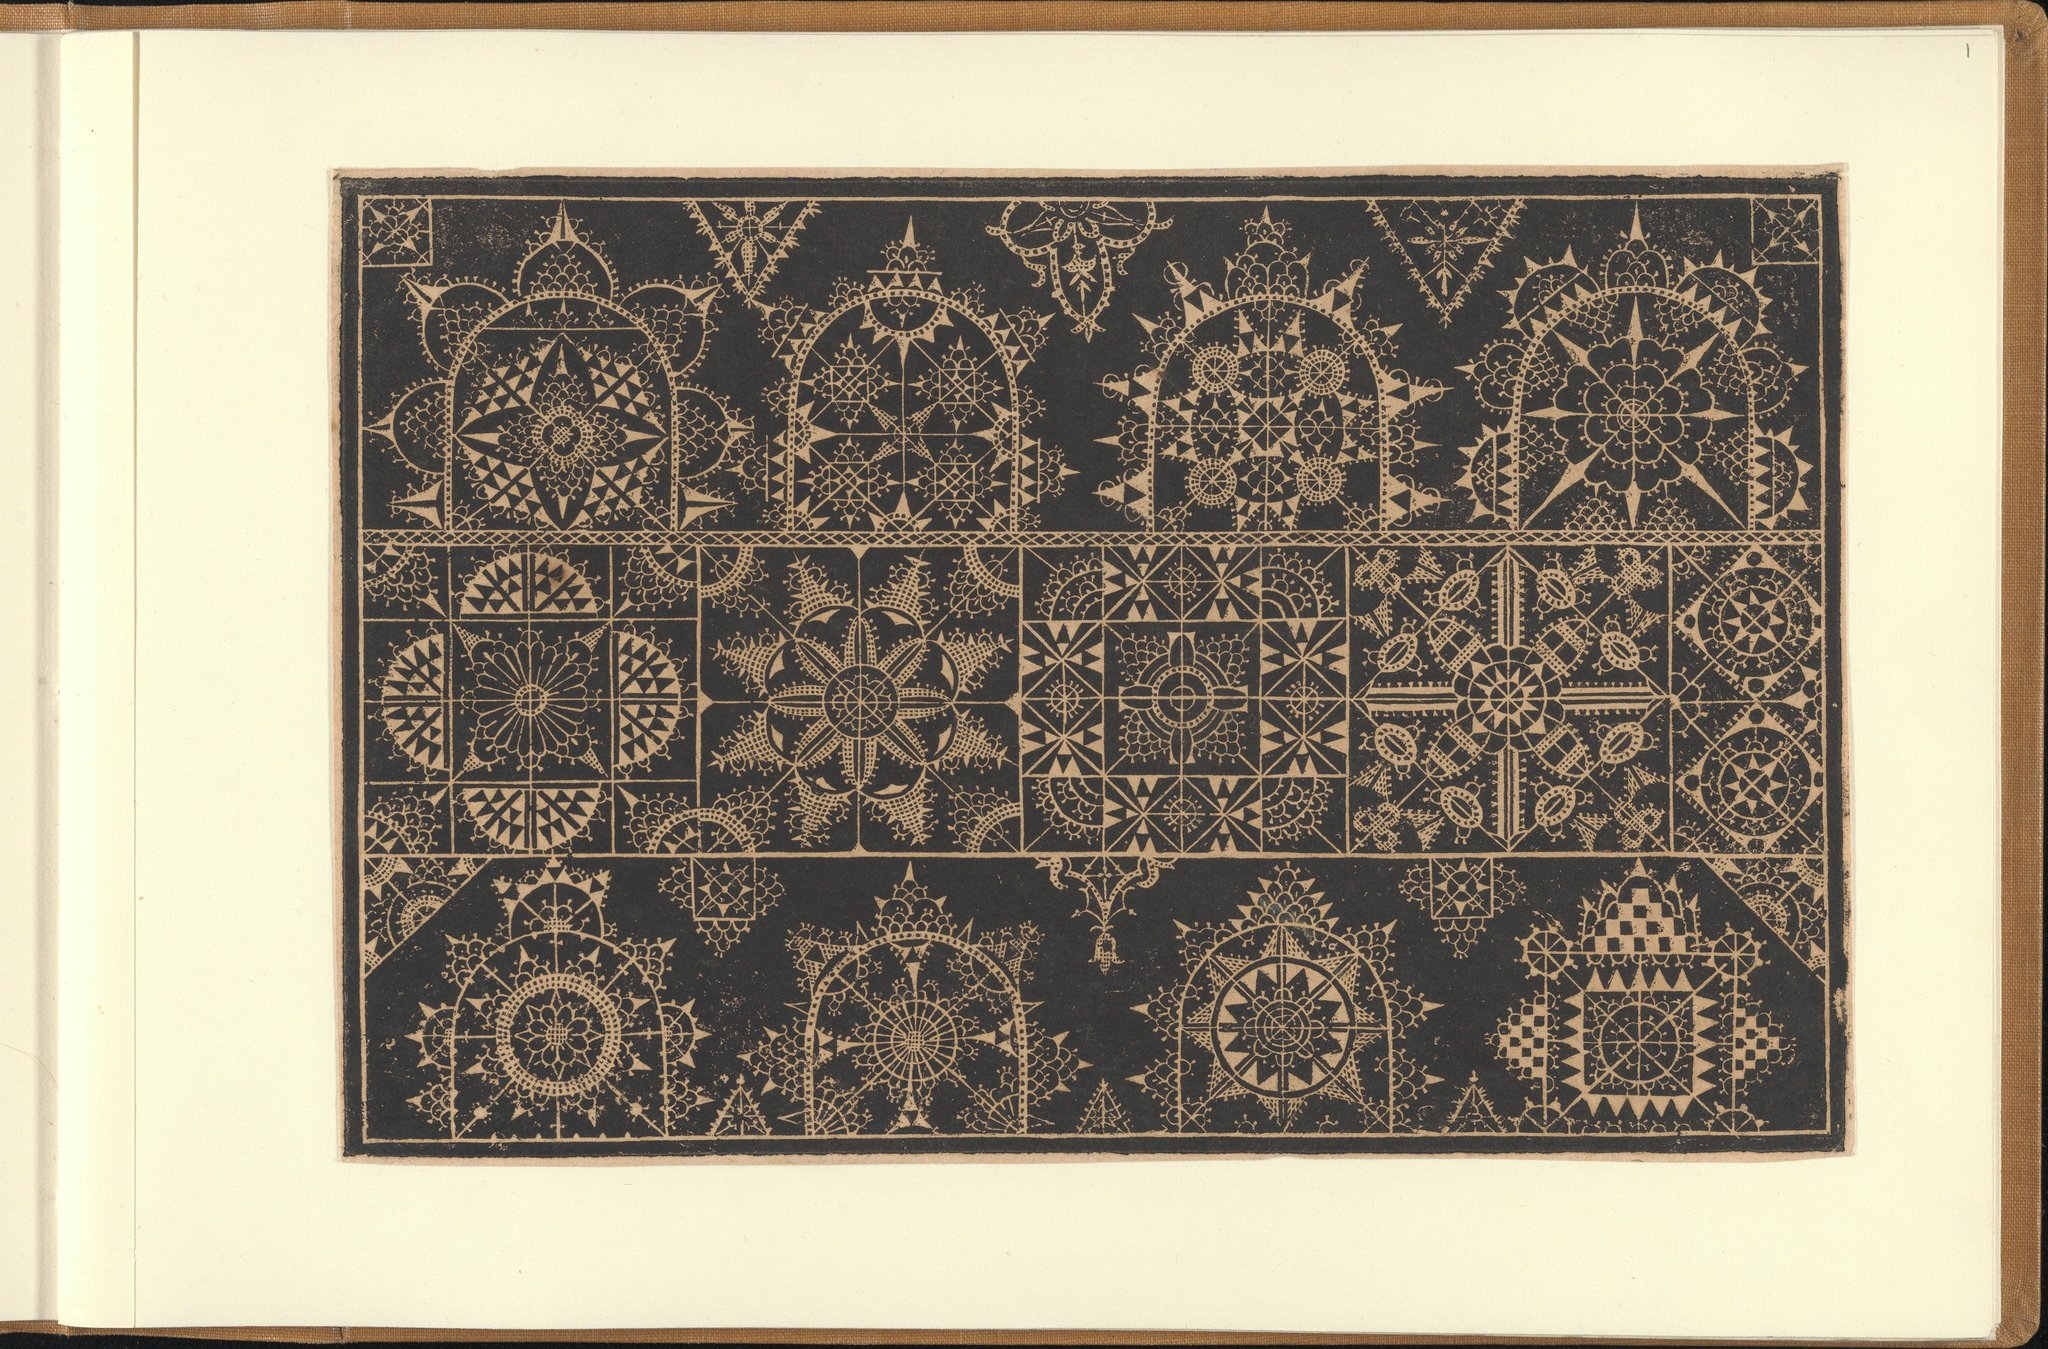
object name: album print ornament architecture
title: Schon newes Modelbuch...Page 1(r)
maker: sigismundus latomus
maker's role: designer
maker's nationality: german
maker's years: 1599-1632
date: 1617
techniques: woodcut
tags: flowers